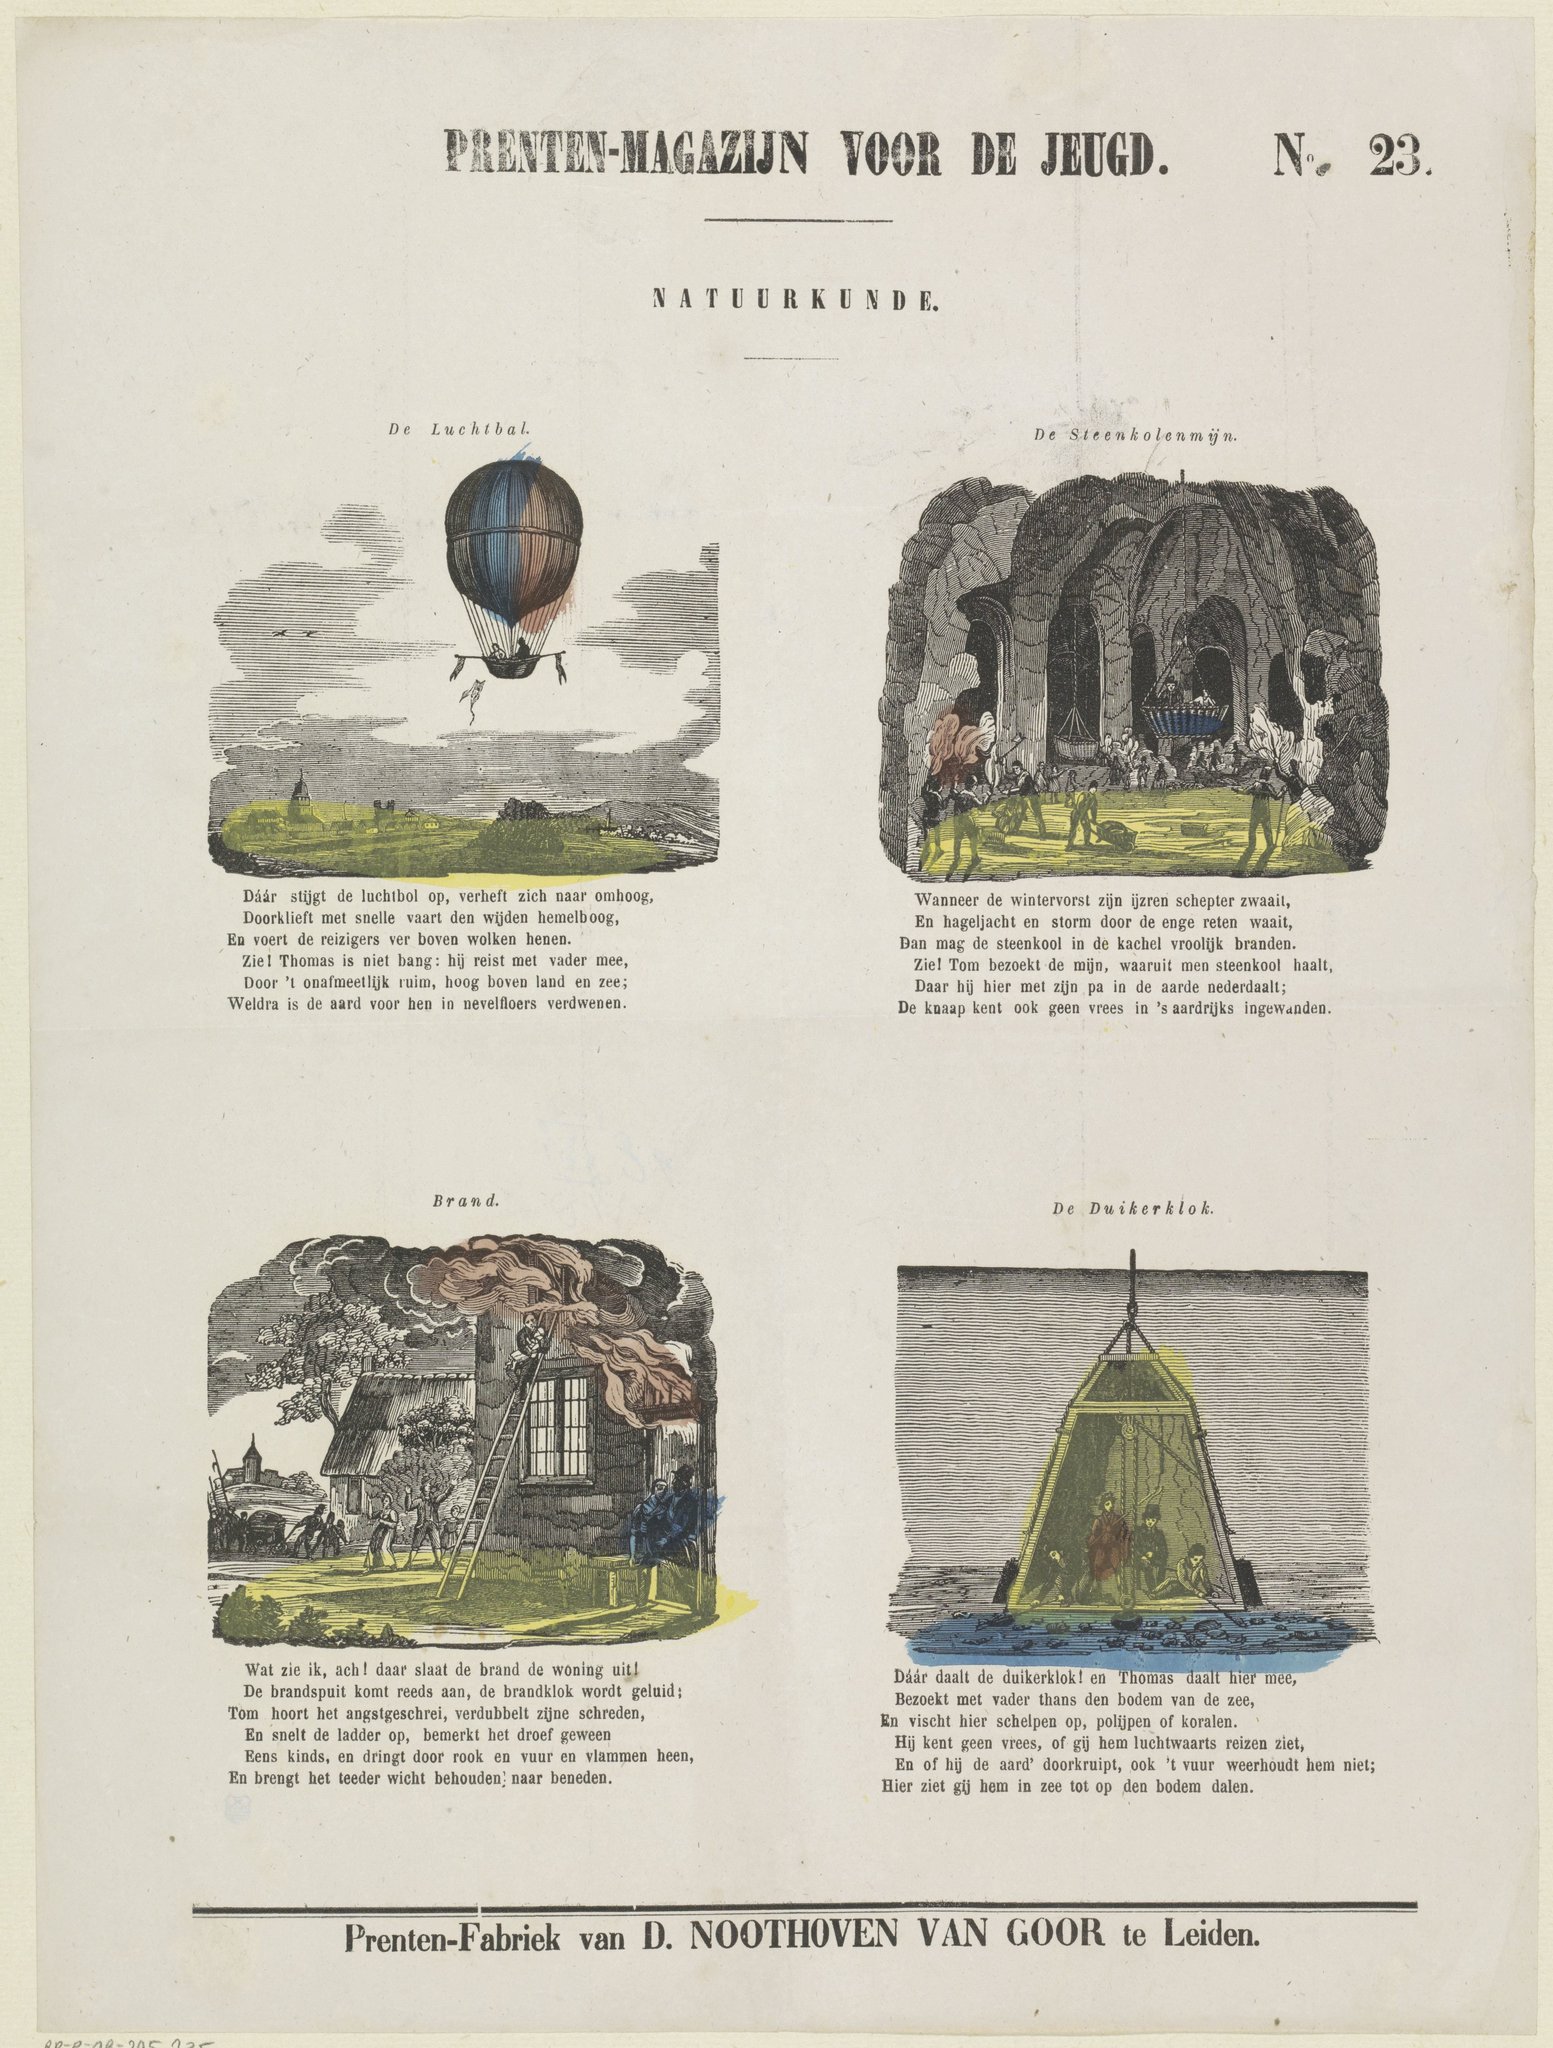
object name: popular print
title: Prenten-magazijn voor de jeugd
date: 1850-1881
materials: paper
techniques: colour, letterpress printing, engraving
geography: netherlands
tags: on fire, ablaze, (flying a) gas balloon, balloon flight (sport), diving-bell, bathysphere, mine (+ coal), mine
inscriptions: collector's mark: Lugt 2760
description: Blad met 4 voorstellingen van natuurkundige zaken: een luchtballon, een steenkolenmijn, brand en een duikerklok. Boven elke voorstelling een titel en onder elke voorstelling een zesregelig vers. Genummerd rechtsboven: No. 23.